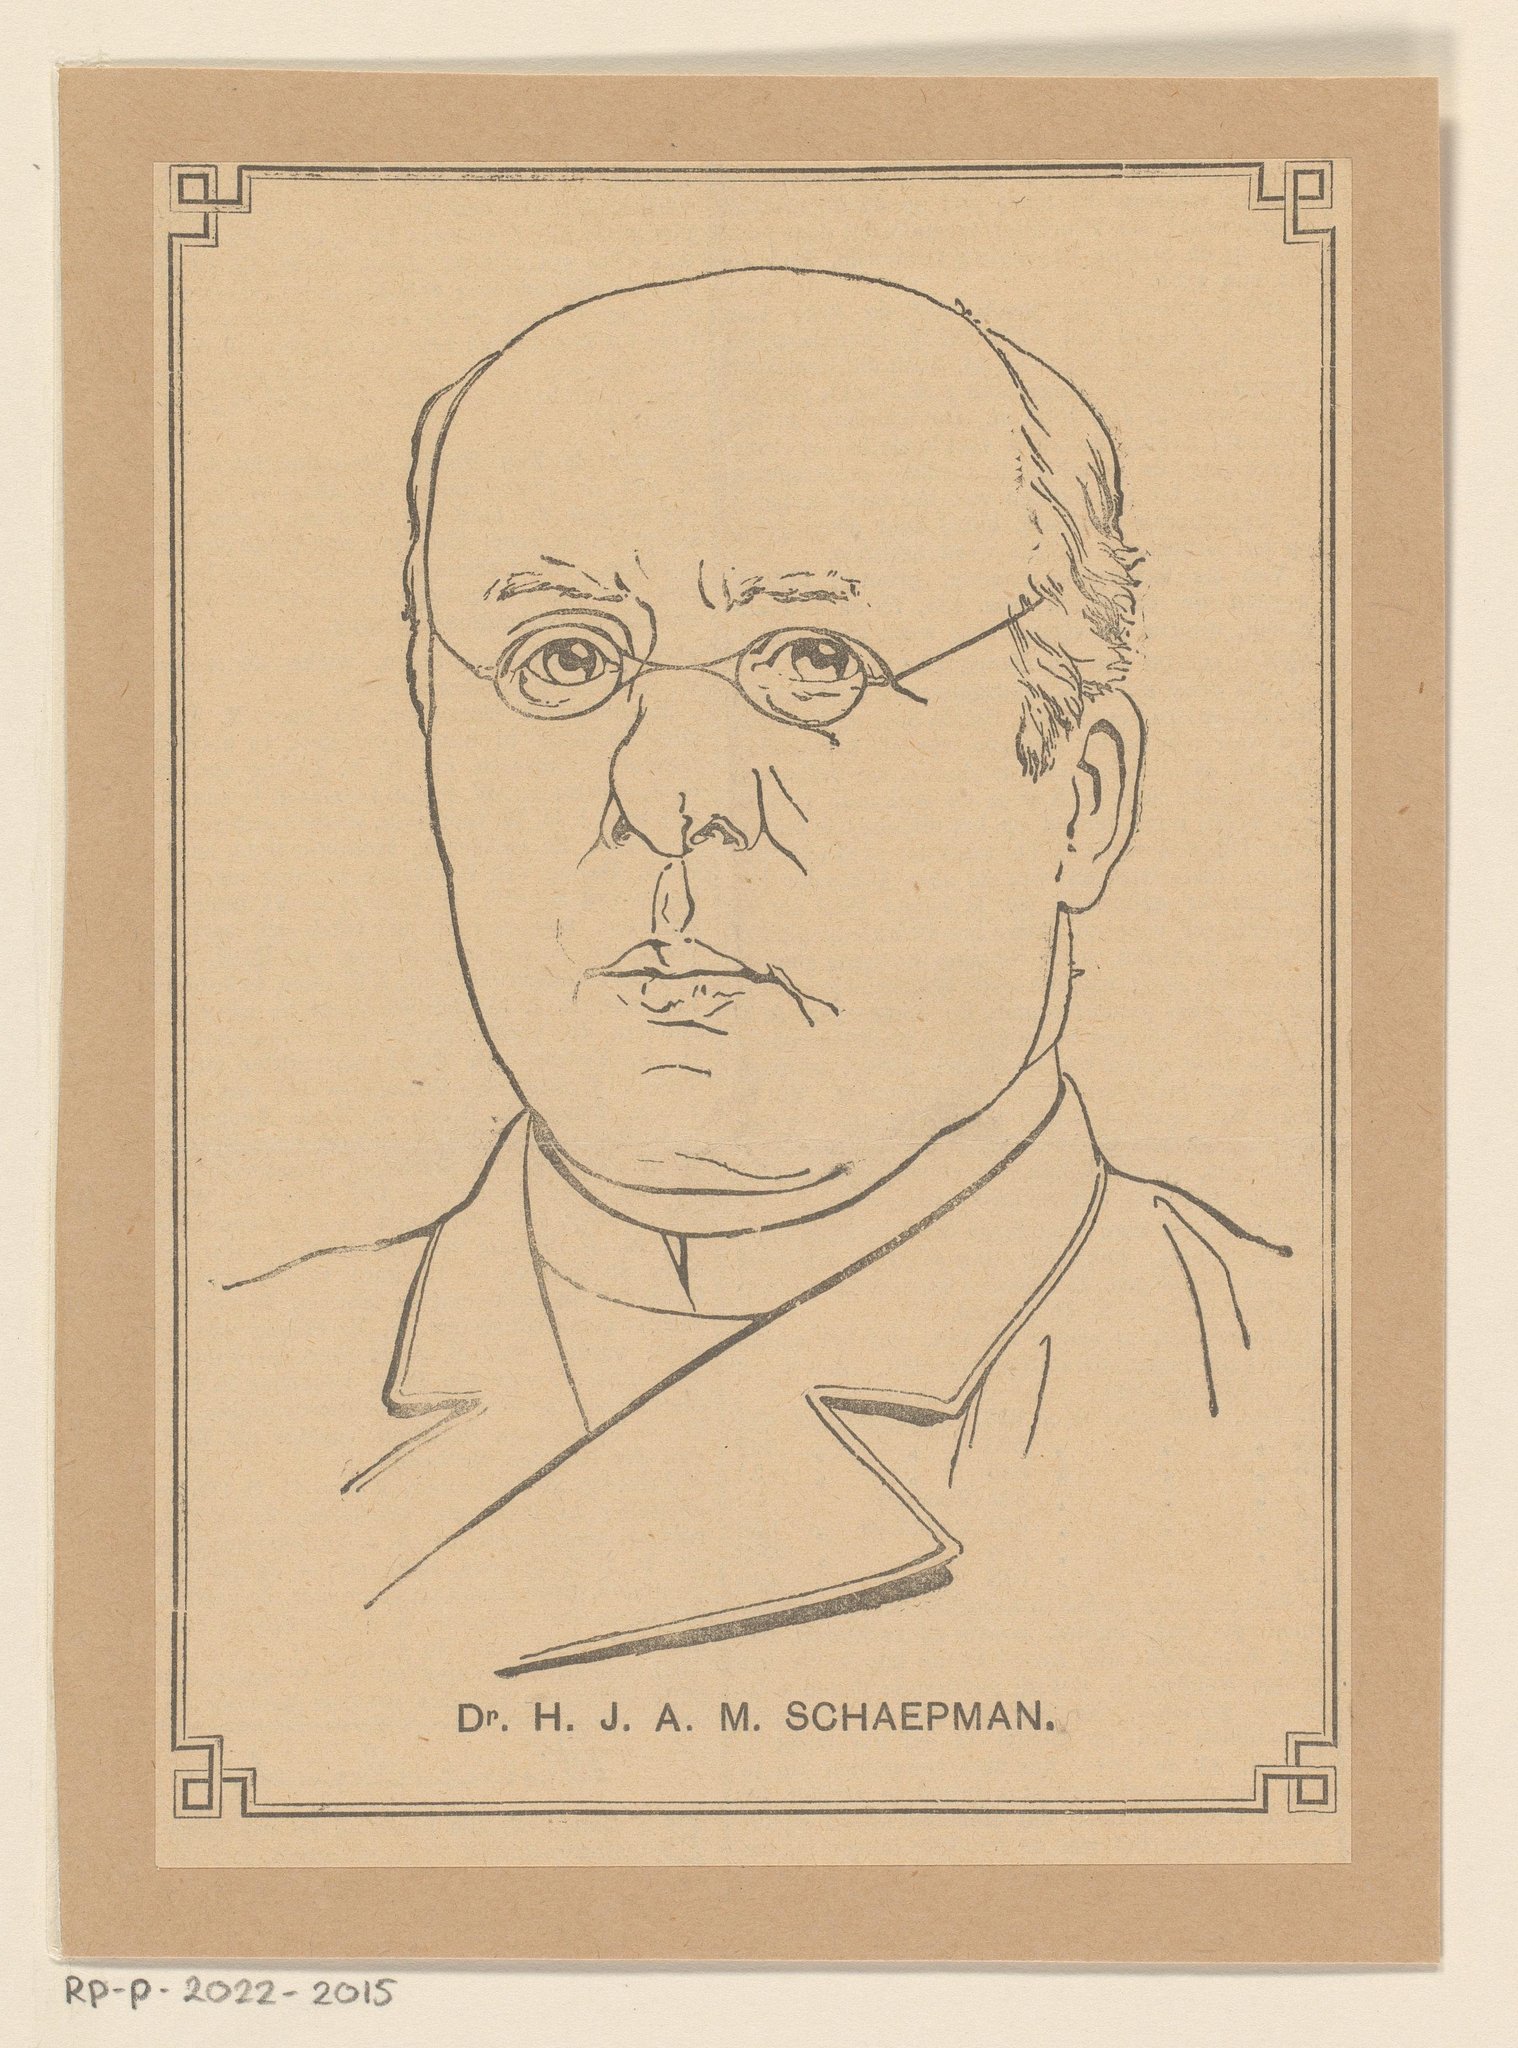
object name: print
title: Portret van Herman Johannes Aloysius Maria Schaepman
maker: Anonymous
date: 1884-1950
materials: paper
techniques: letterpress printing, snipping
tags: priest, herman johannes aloysius maria schaepman, theologian, historical persons, politician, e.g. party leader, writer, poet, author